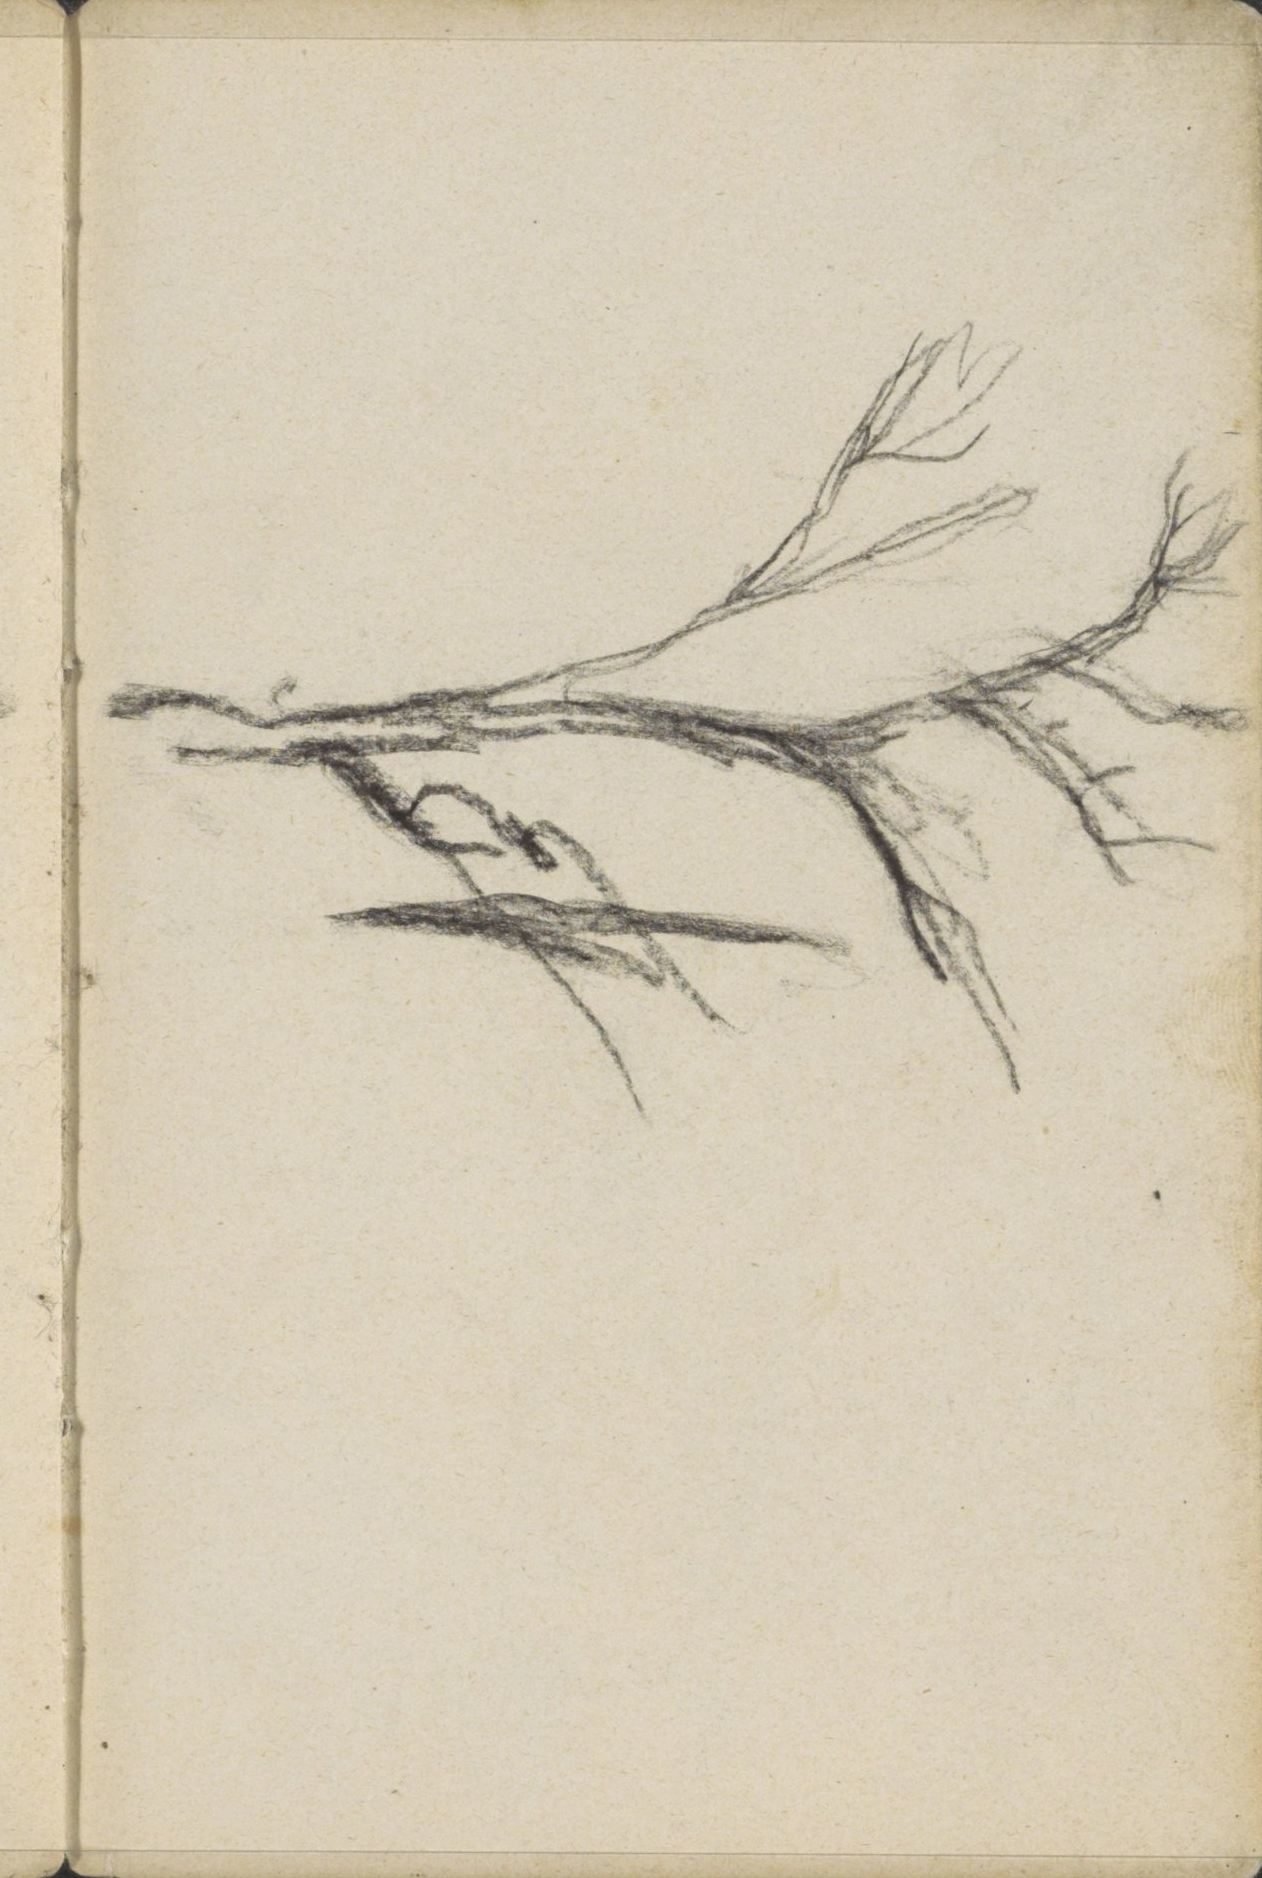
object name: sketchbook leaf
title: Boom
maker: george hendrik breitner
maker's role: draughtsman, painter, print maker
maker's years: 1857-1923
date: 1902-1914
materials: chalk, paper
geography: amsterdam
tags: trees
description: Boom. Pagina 92 uit een schetsboek met 46 bladen vervaardigd te Noord-Holland en Utrecht.